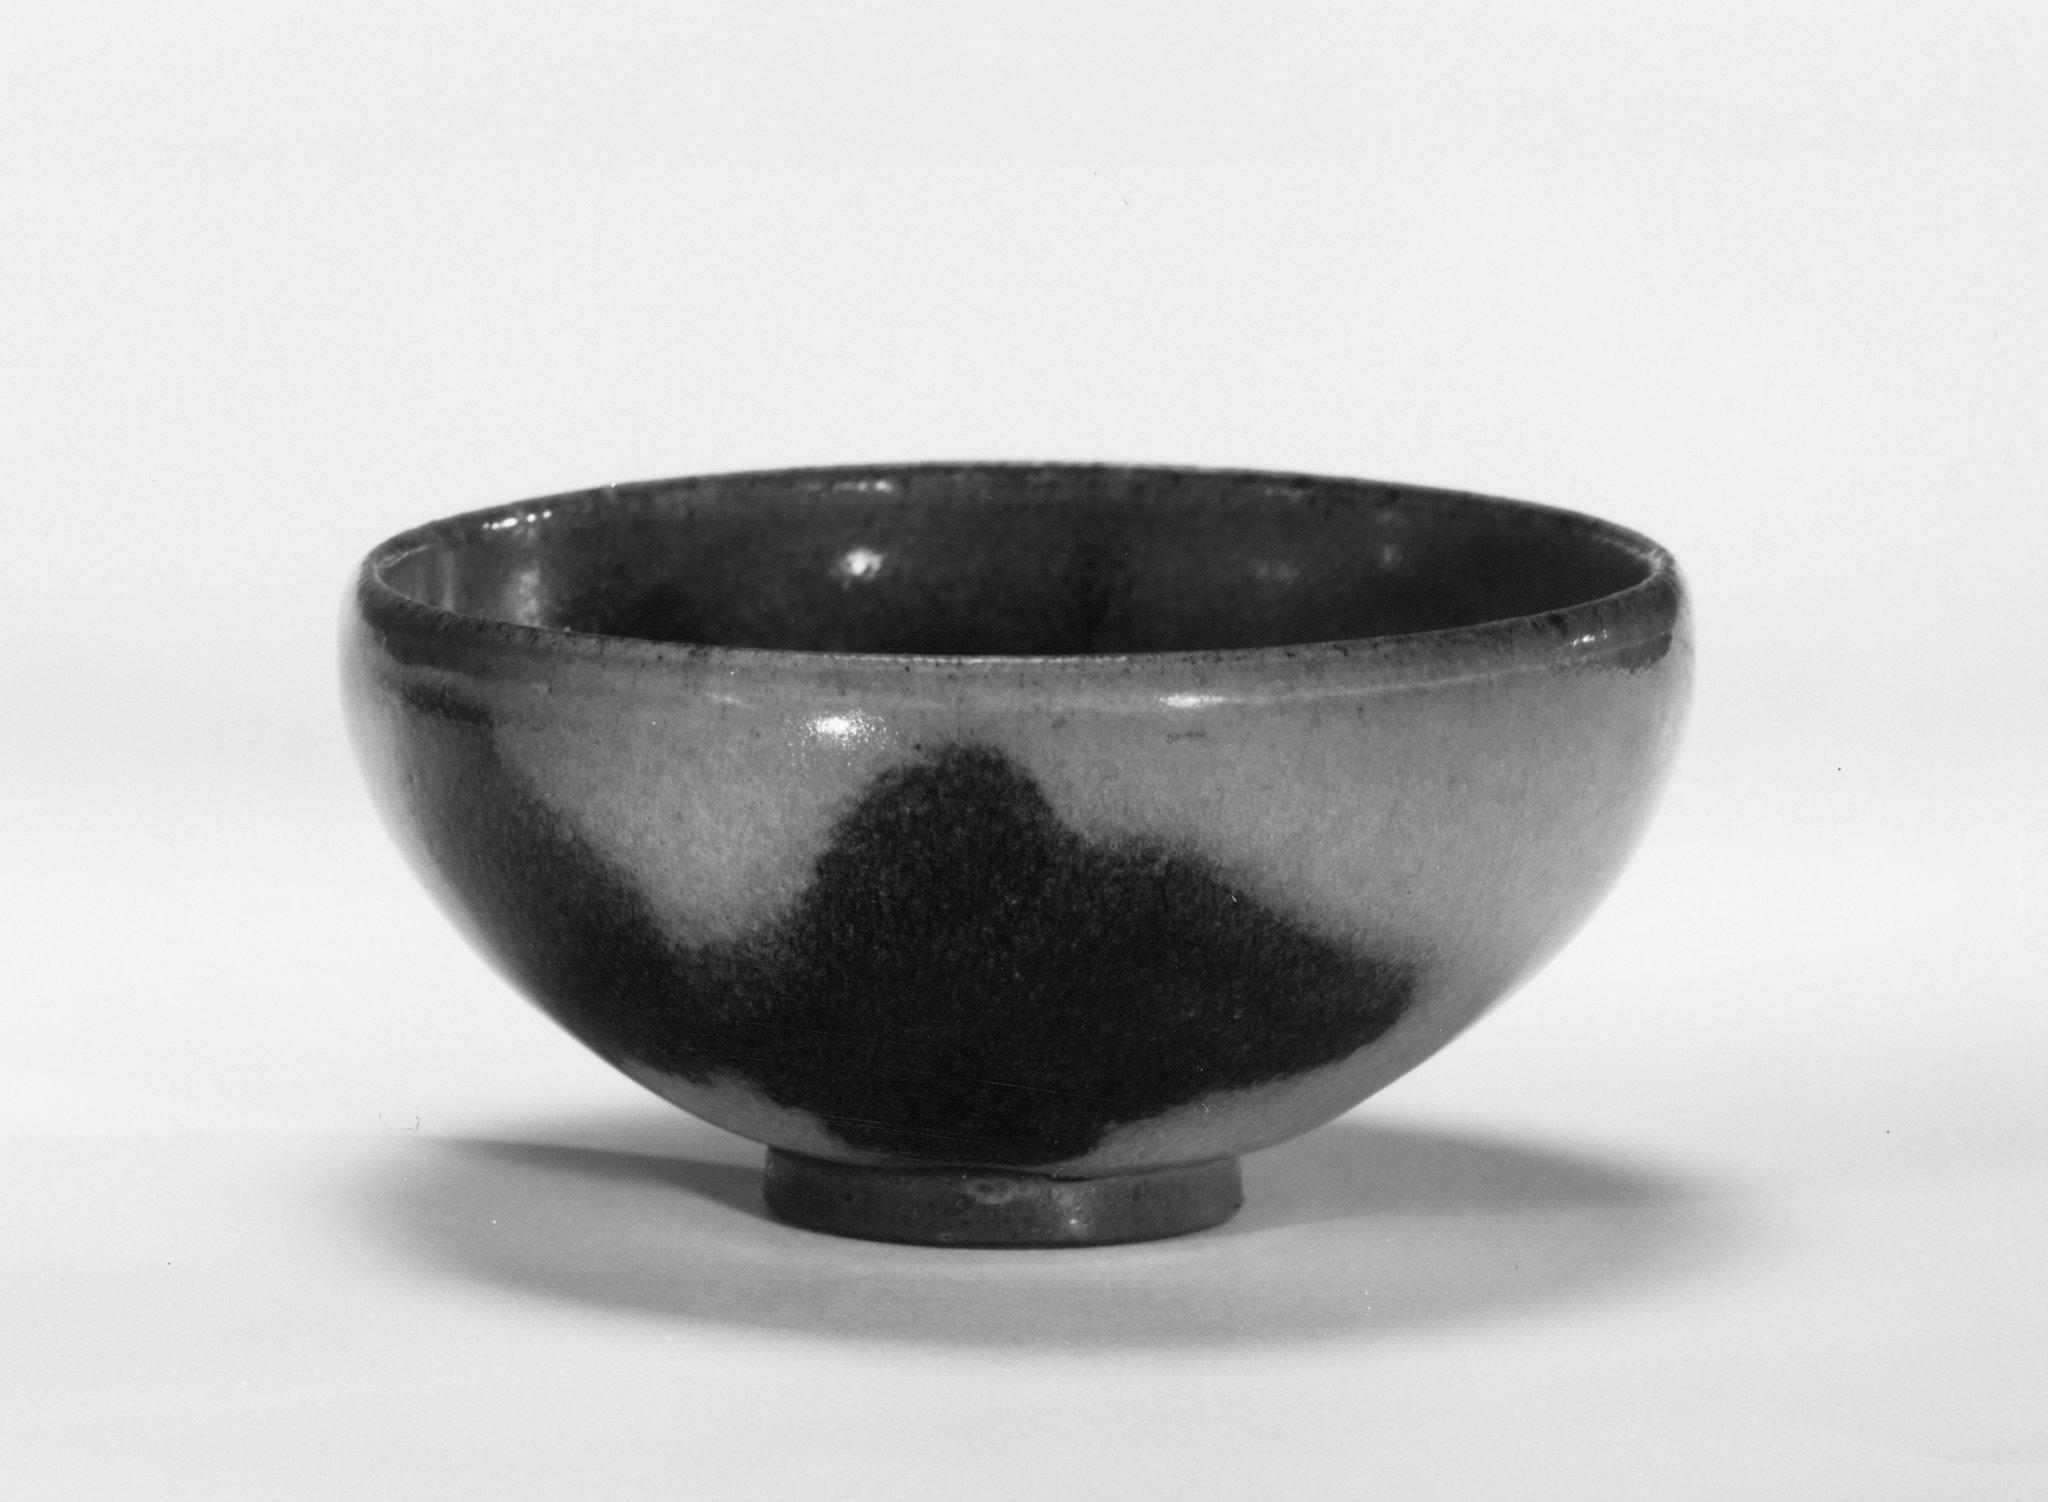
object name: bowl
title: Small Bowl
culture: chinese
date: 1101-1300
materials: glaze, stoneware